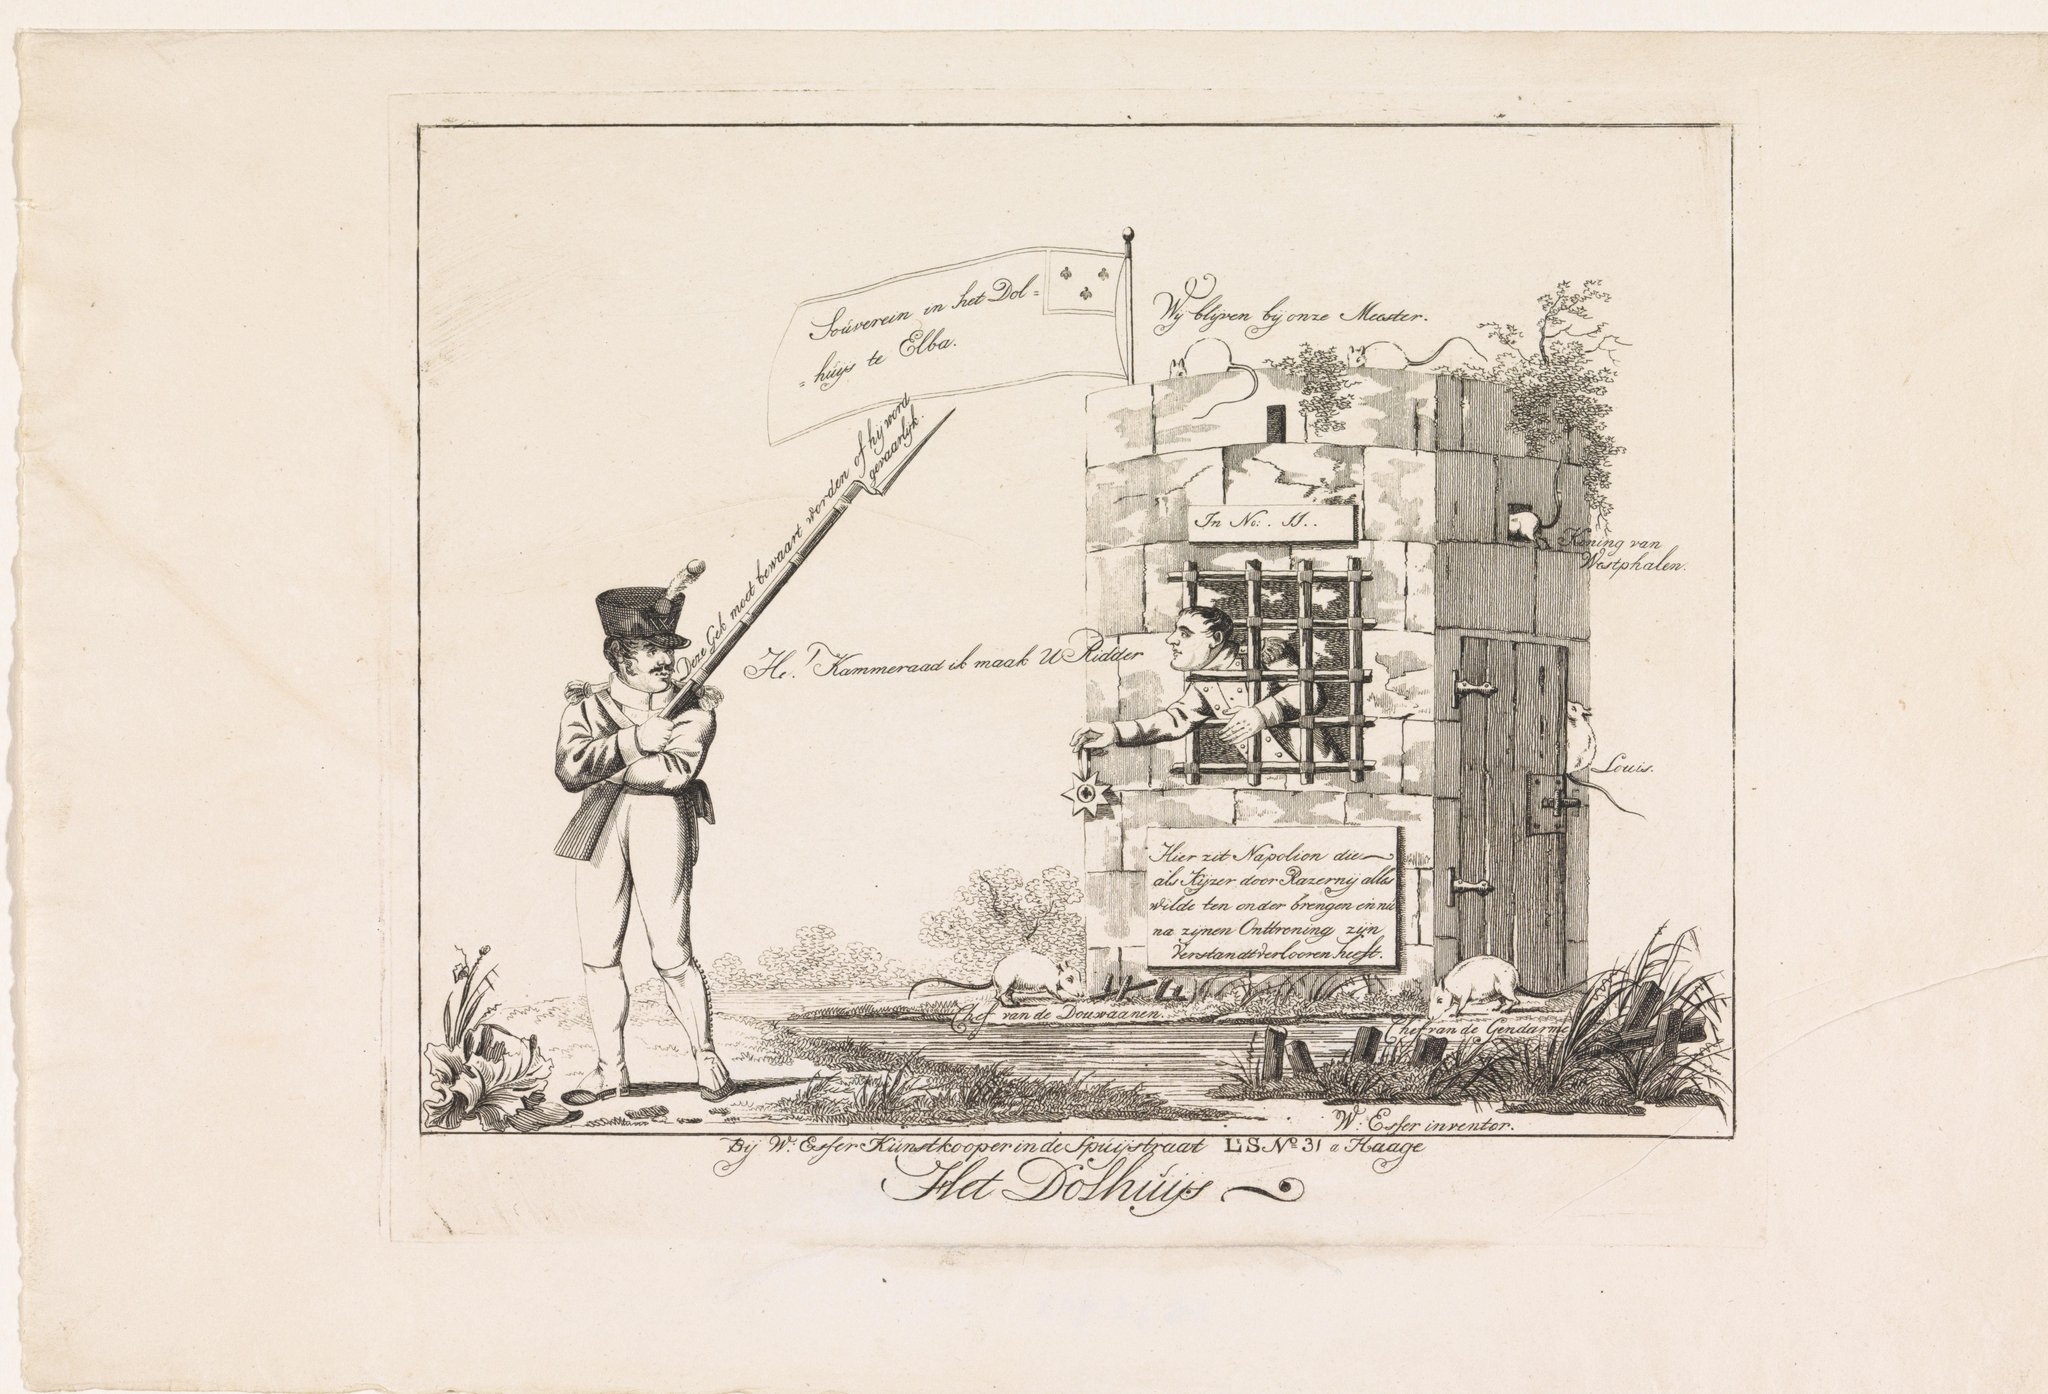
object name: print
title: Het Dolhuijs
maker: wijnand esser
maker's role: draughtsman, print maker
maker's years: 1779-1860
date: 1814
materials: paper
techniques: engraving, etching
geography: the hague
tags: napoleon i (emperor of the french), prison, jail, lunatic asylum, mental home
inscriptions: collector's mark: Lugt 2228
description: Spotprent op Napoleons ballingschap op Elba, 1814. Napoleon als een gevaarlijke gek opgesloten in een stenen dolhuis. Hij probeert een bewaker om te kopen met een ridderkruis om hem vrij te laten. Op en rondom de gevangenis lopen ratten. Bovenop het gebouw wappert een vlag met het opschrift 'Souverein in het Dolhuijs te Elba'.